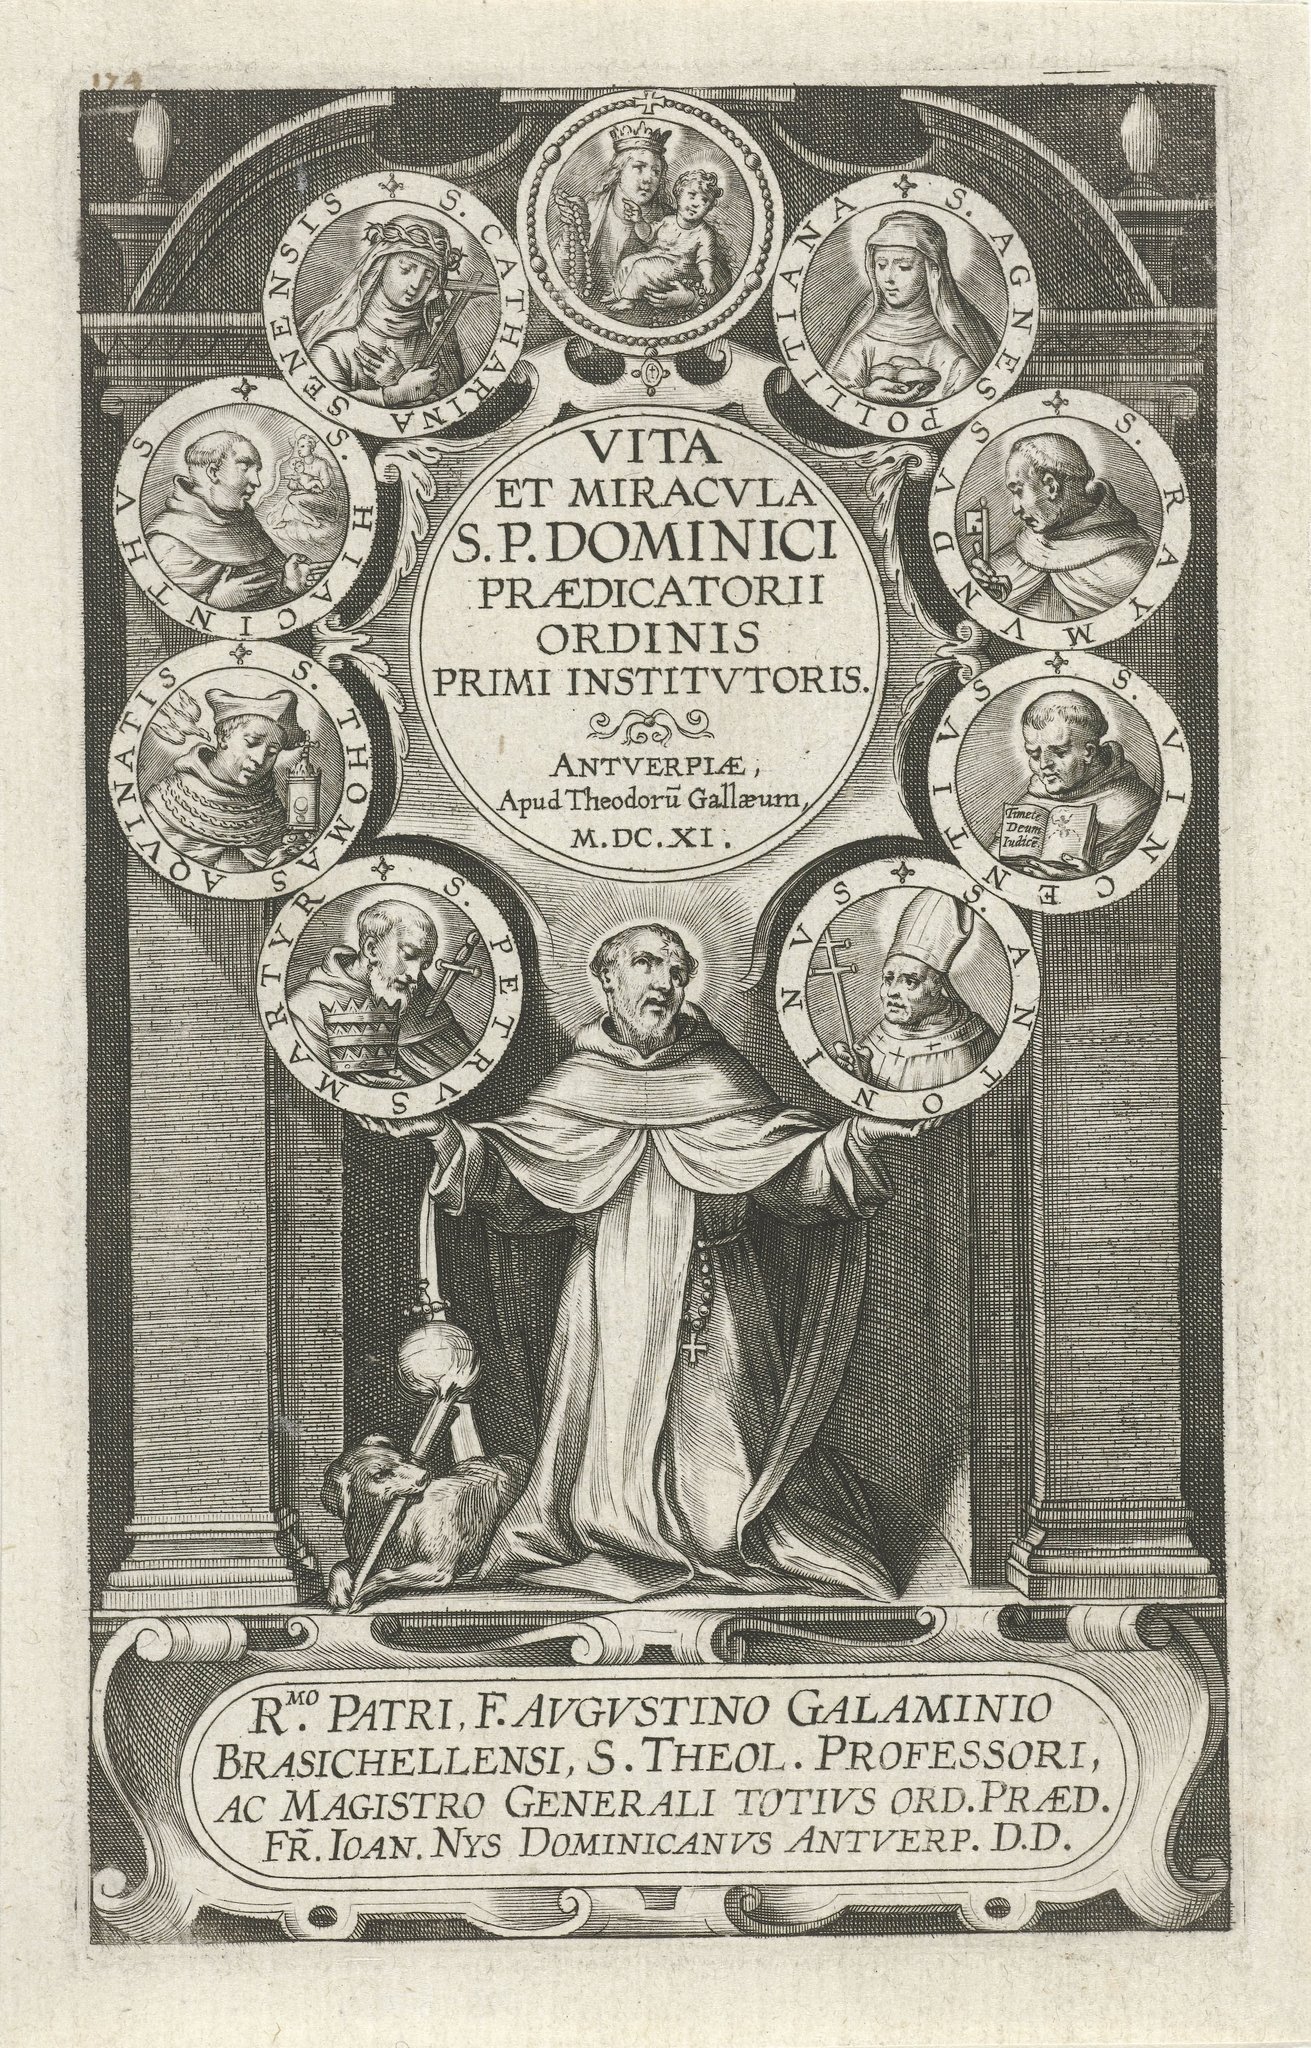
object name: print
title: Titelpagina voor: Augustino Galaminio, Vita et miracula S.P. Dominici praedicatorii ordinis primi institutoris, 1611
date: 1611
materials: paper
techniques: engraving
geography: antwerp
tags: dominic(us) guzman of calerueja, founder of the order of preachers (or dominican (black) friars; possible attributes: book, dog with flaming torch, lily, loaf of bread, rosary, star, the virgin and dominican tertiary, catherine of siena; possible attributes: book, cross, crown of thorns, crucifix, demon under foot, heart (with cross), lily, plague-stricken, ring, rosary, stigmata, the dominican friar vincent ferrer of valencia (or vannes); possible attributes: book, baptismal font, cardinal's hat at feet, flames, flaming sword, ihs monogram, lily, sun, trumpet of the last judgement, the dominican theologian, 'angelic doctor' thomas of aquino; possible attributes: book, (chain with) sun, dove, girdle of chastity, lily, model of church, monstrance (or chalice), mitre (under feet), star (on breast), female saints (with name), male saints (with name), the dominican friar hyacinth(us) of poland; possible attributes: book, lily, monstrance (or ciborium), statue of the virgin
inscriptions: collector's mark: Lugt 2228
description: De heilige Dominicus zit geknield op de vloer tussen twee pilaren. Hij houdt negen portretten omhoog met belangrijke Dominicaanse heiligen (de heilige Petrus Martyr, de heilige Thomas van Aquino, de heilige Hyacintus, de heilige Catharina van Siena, de heilige Agnes, de heilige Raimondus, de heilige Vincentius Ferrer en de heilige Antonius). De prent is de titelpagina voor een boek over het leven van de heilige Dominicus.